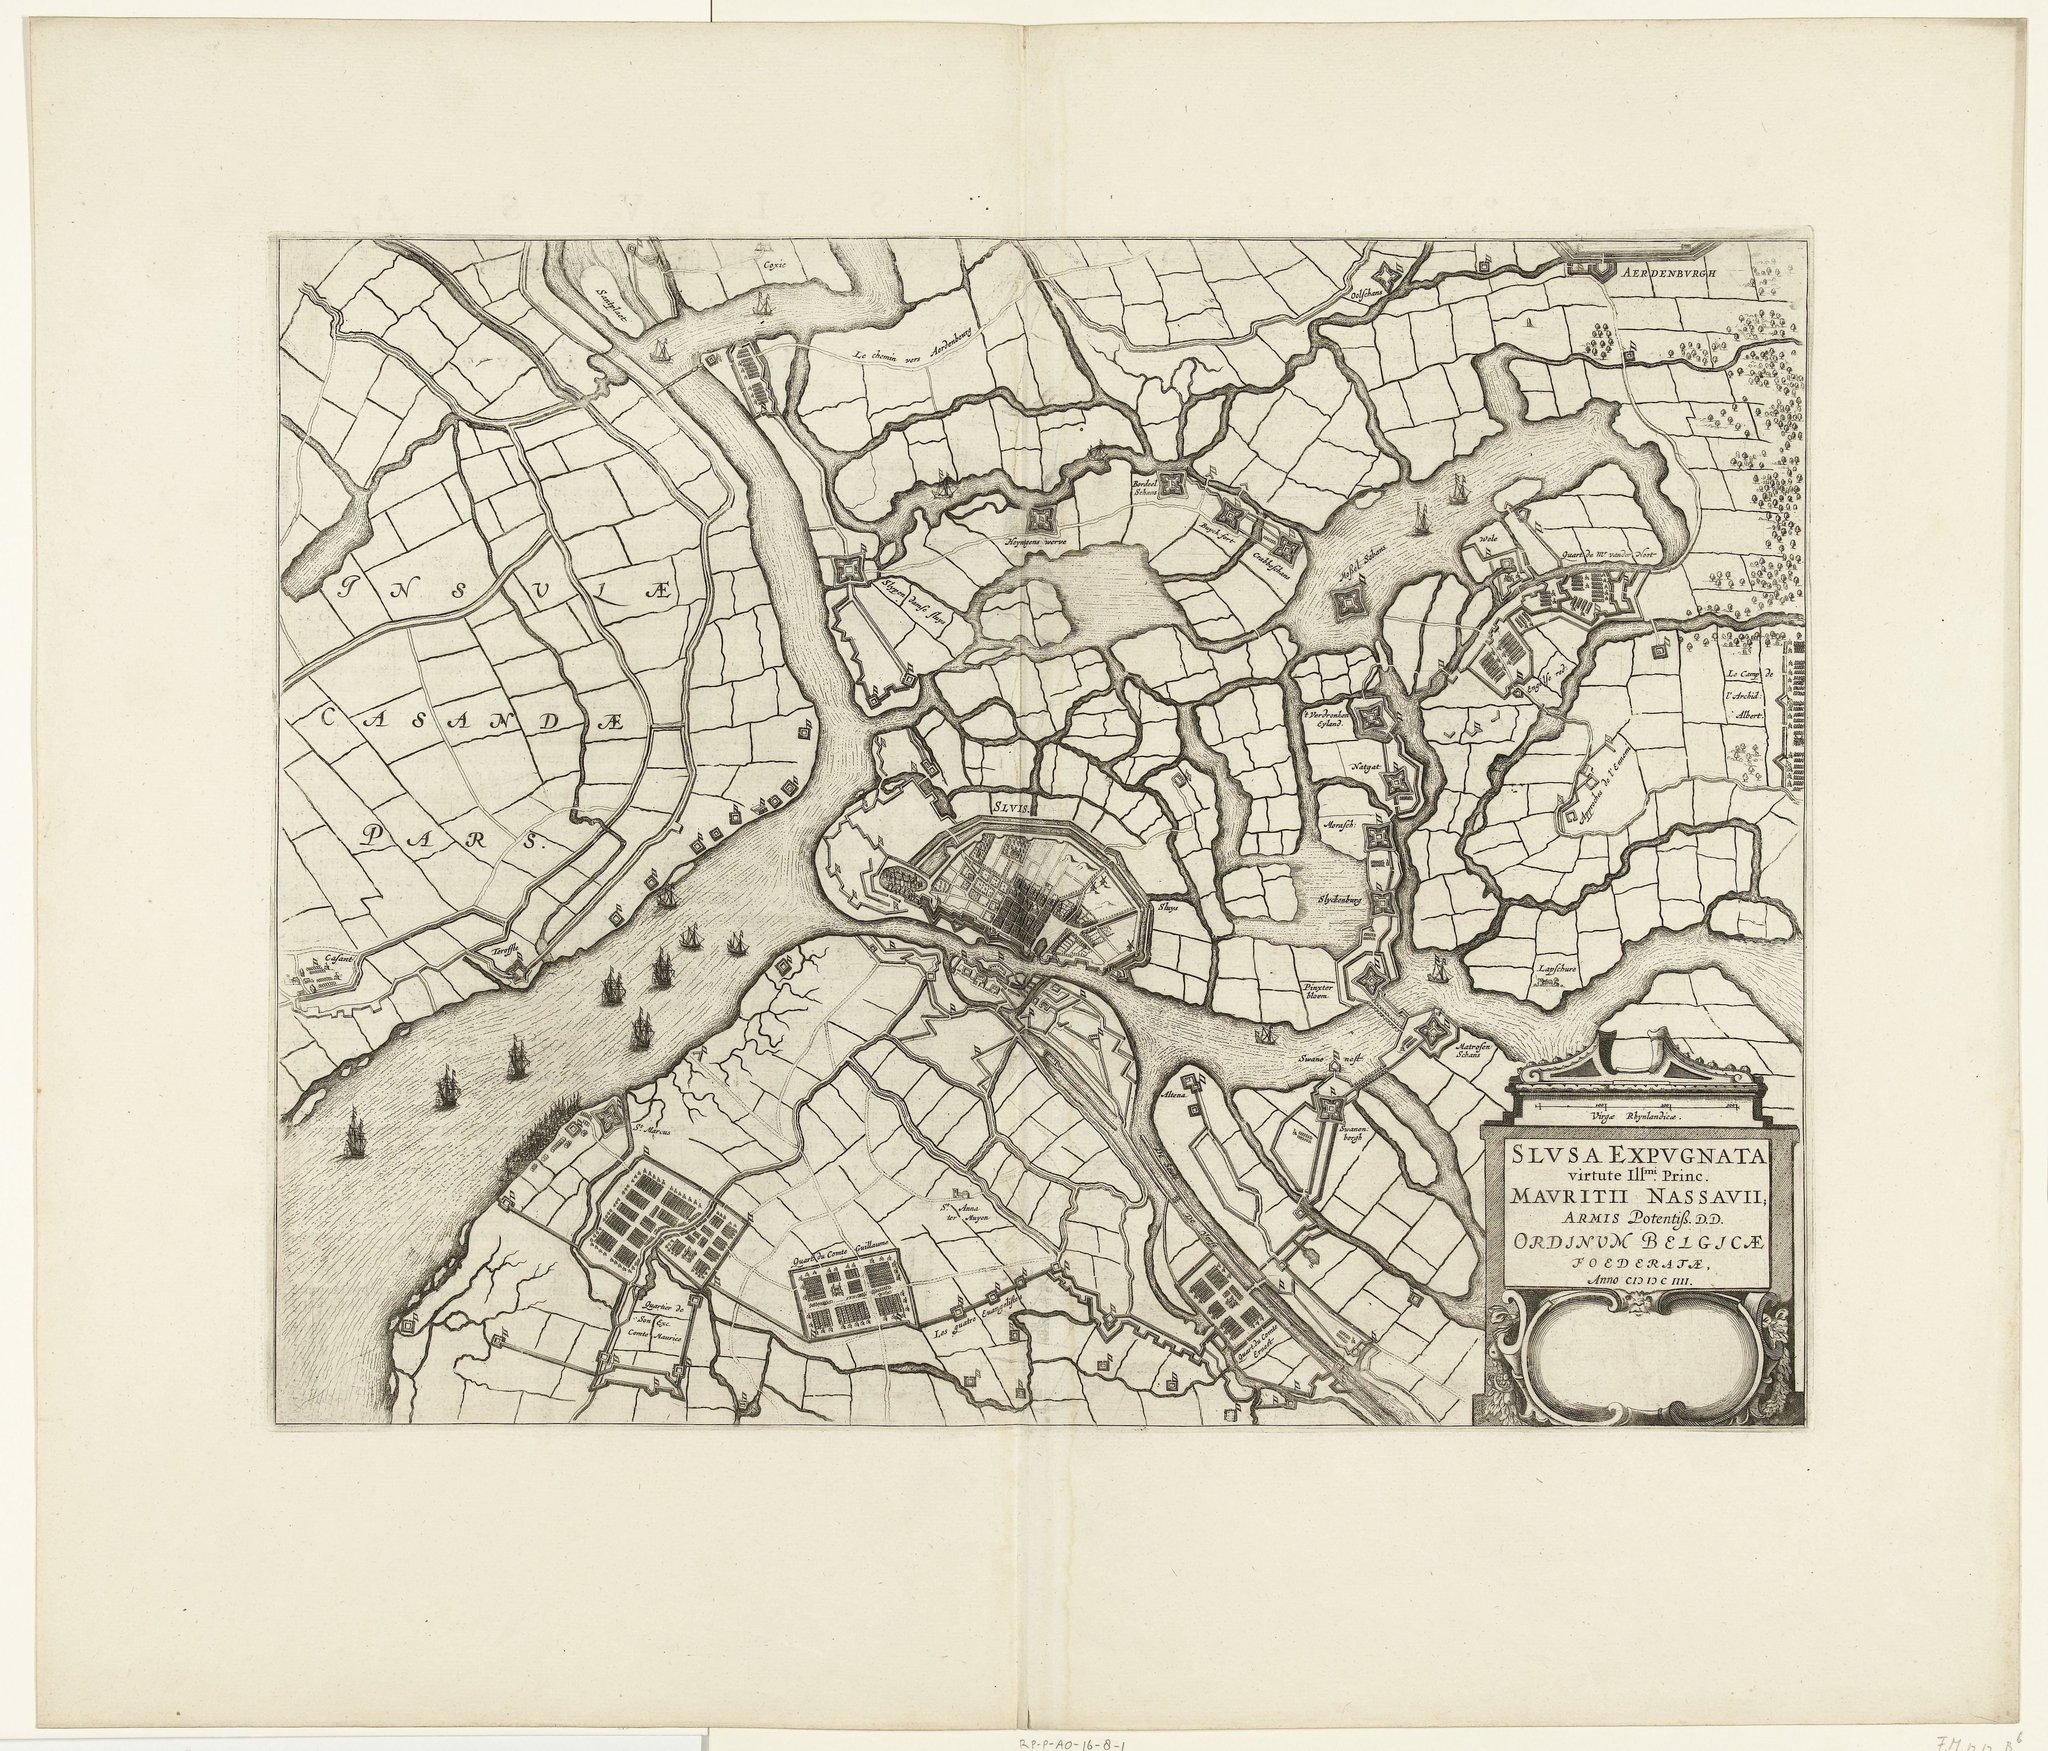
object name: print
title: Slusa, Obsessa & Expunata, Anno MDCIV, Per Mauritium Nassauium, &c. Foderatae Belgicae Exercitus Ducem, &c.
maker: Anonymous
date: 1647-1649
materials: paper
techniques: etching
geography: northern netherlands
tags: maurice (prince of orange), maps of separate countries or regions, siege, position war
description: Beleg van Sluis door het Staatse leger onder Maurits, begin mei - 19 augustus 1604. Kaart van Sluis en het omliggende gebied tussen Cadzand en Aardenburg met de kwartieren van de belegerende troepen. Rechtsonder een cartouche met de titel in het Latijn. Op een dubbelblad genomen uit het Stedenboek van Blaeu, bedrukt op achterzijde met tekst in het Latijn.